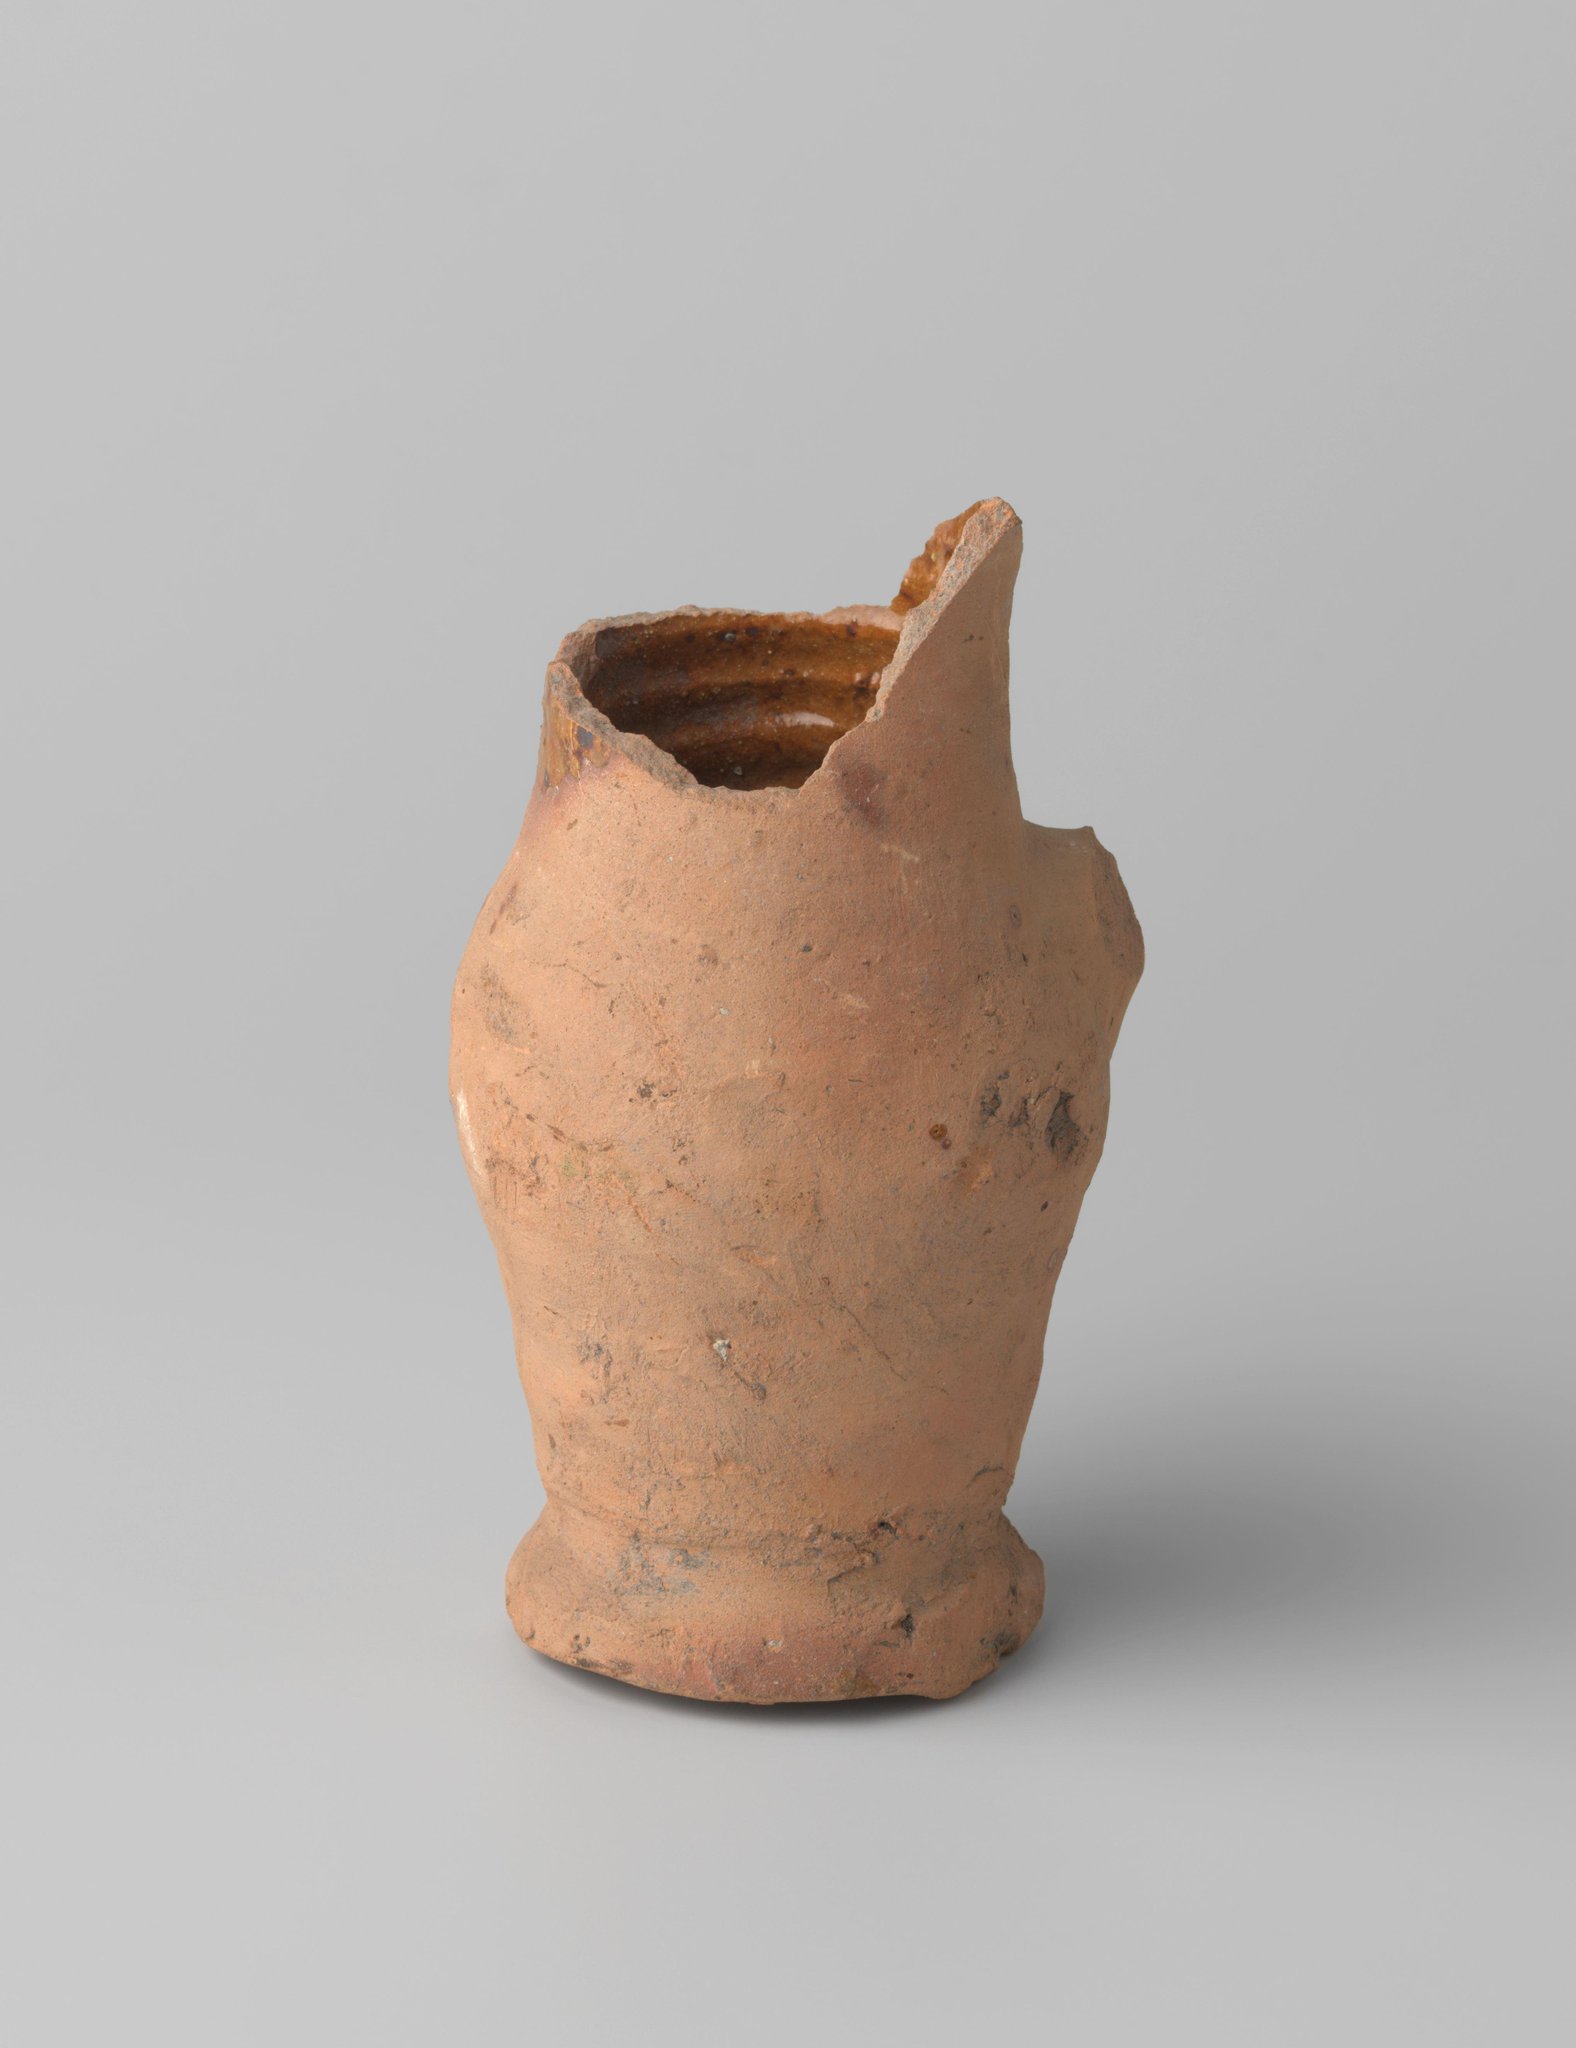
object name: ewer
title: Kan van roodbakkend aardewerk, aan de binnen-en deels de buitenzijde voorzien van glazuur, met beschadigde rand, voet en oor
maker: Anonymous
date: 1500-1799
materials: earthenware, glaze